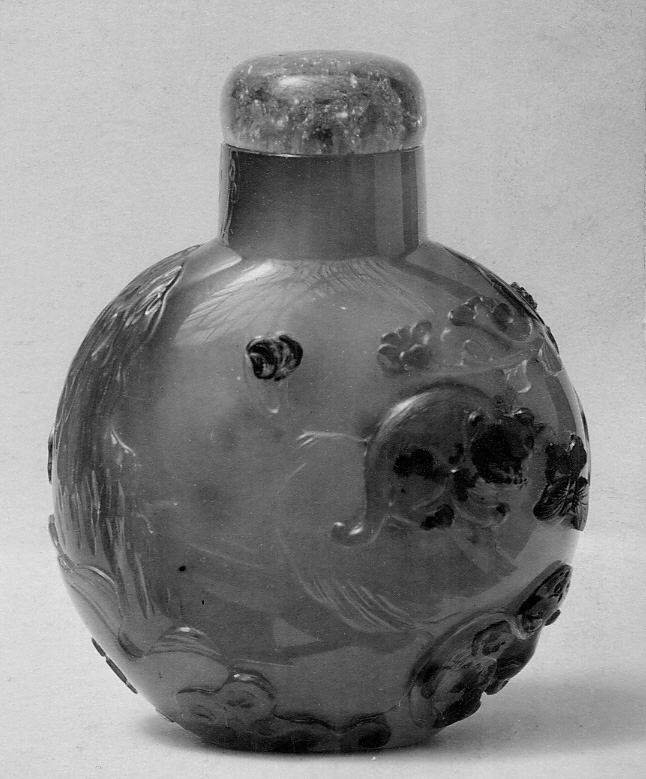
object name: snuff bottle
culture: chinese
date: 1801-1900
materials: stone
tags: cats,butterflies